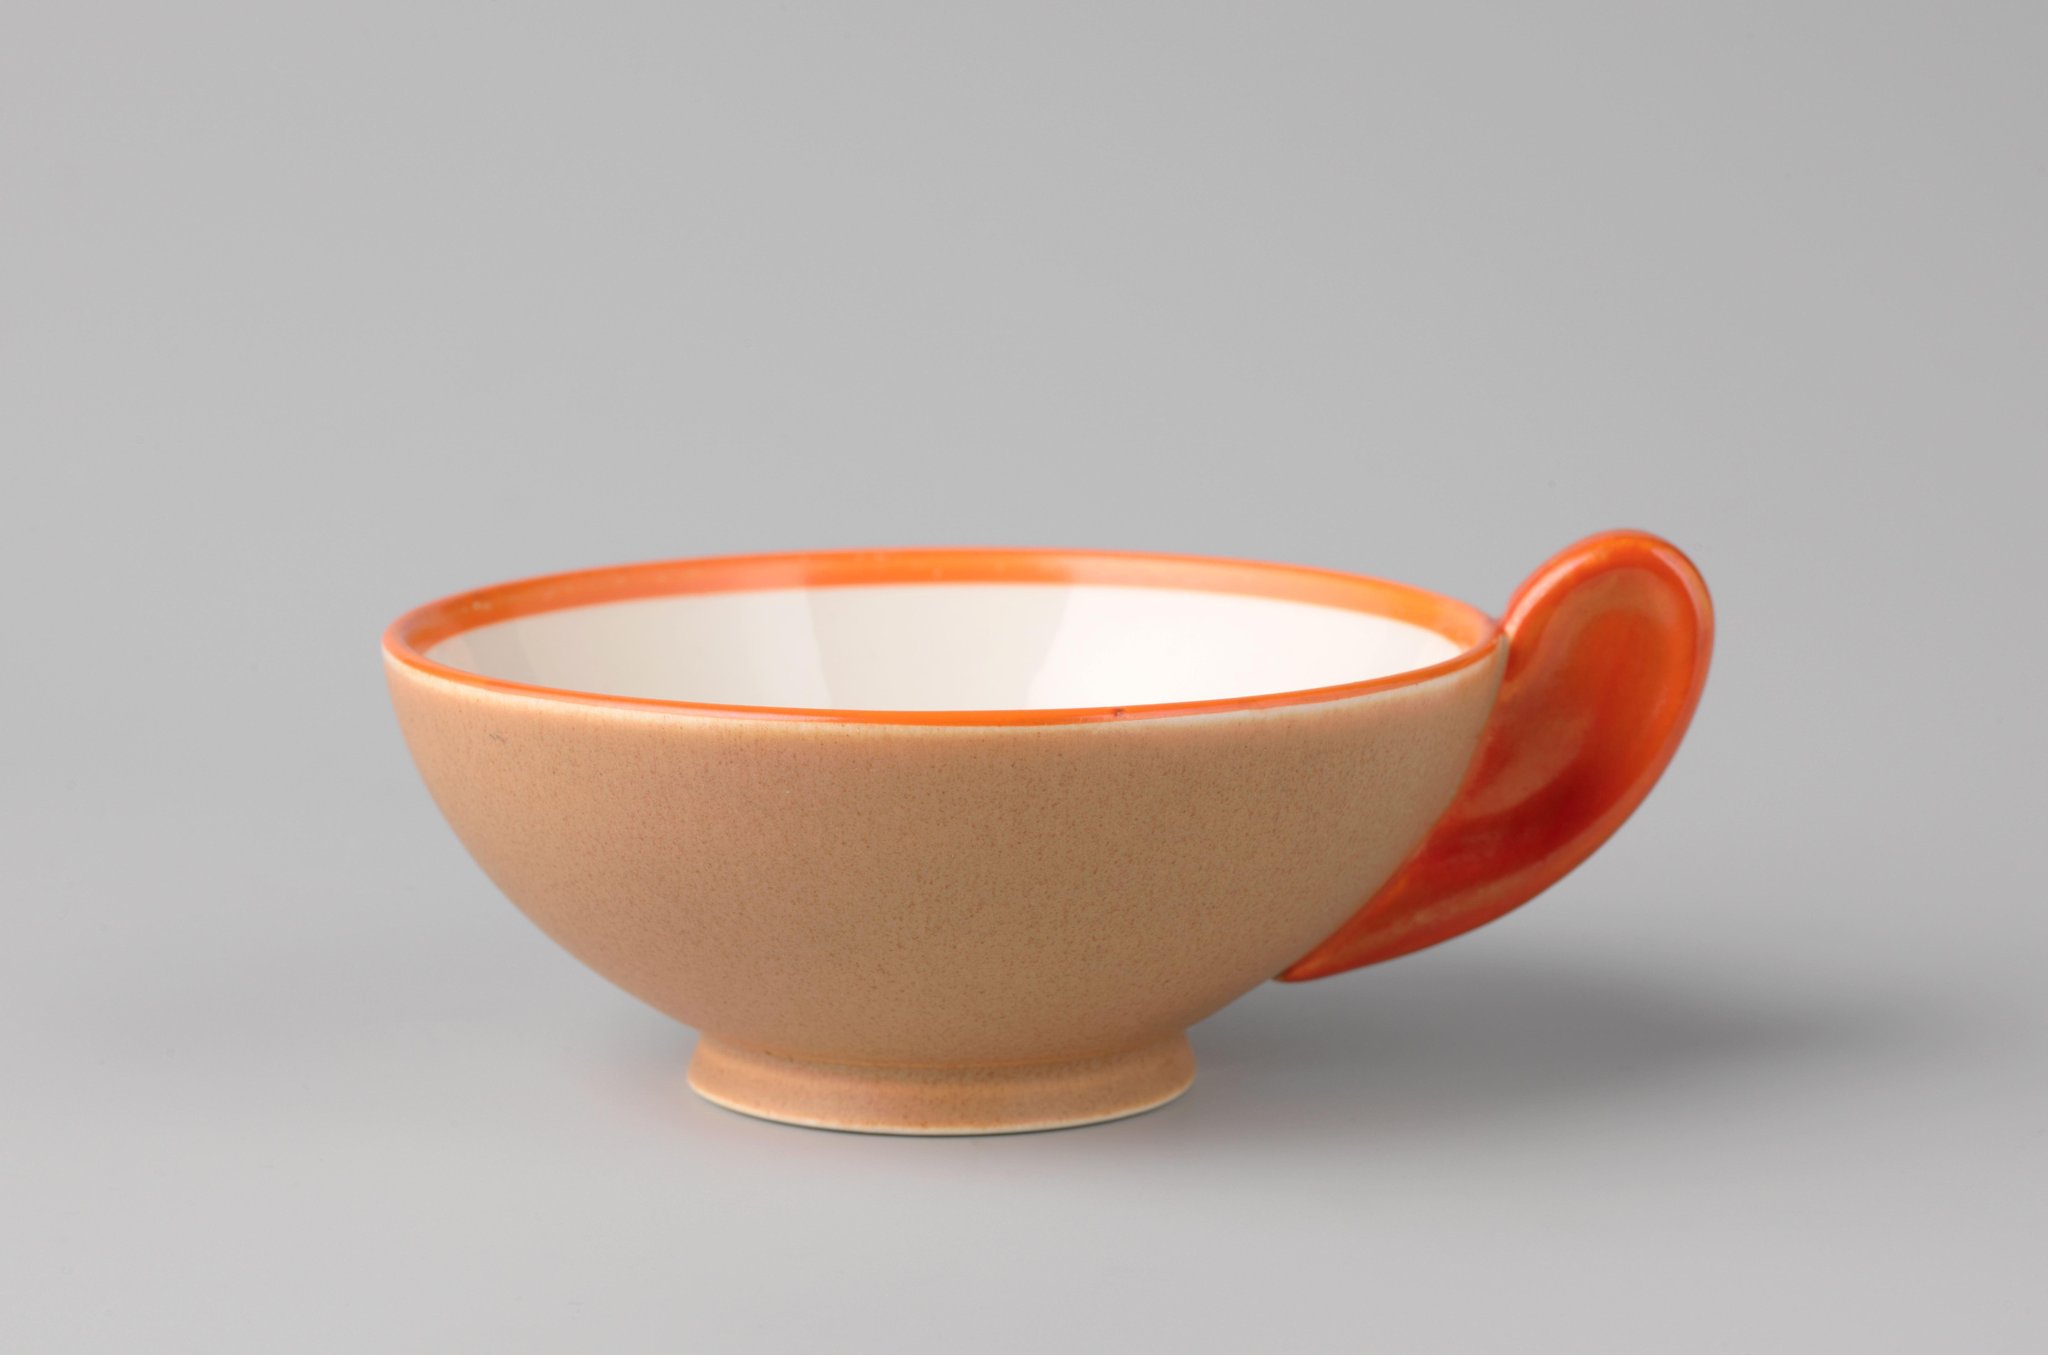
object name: tea cup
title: Theekop, deel van een theeservies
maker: edmond bellefroid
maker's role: ceramicist, painter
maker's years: 1893-1971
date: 1934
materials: earthenware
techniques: painted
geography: maastricht